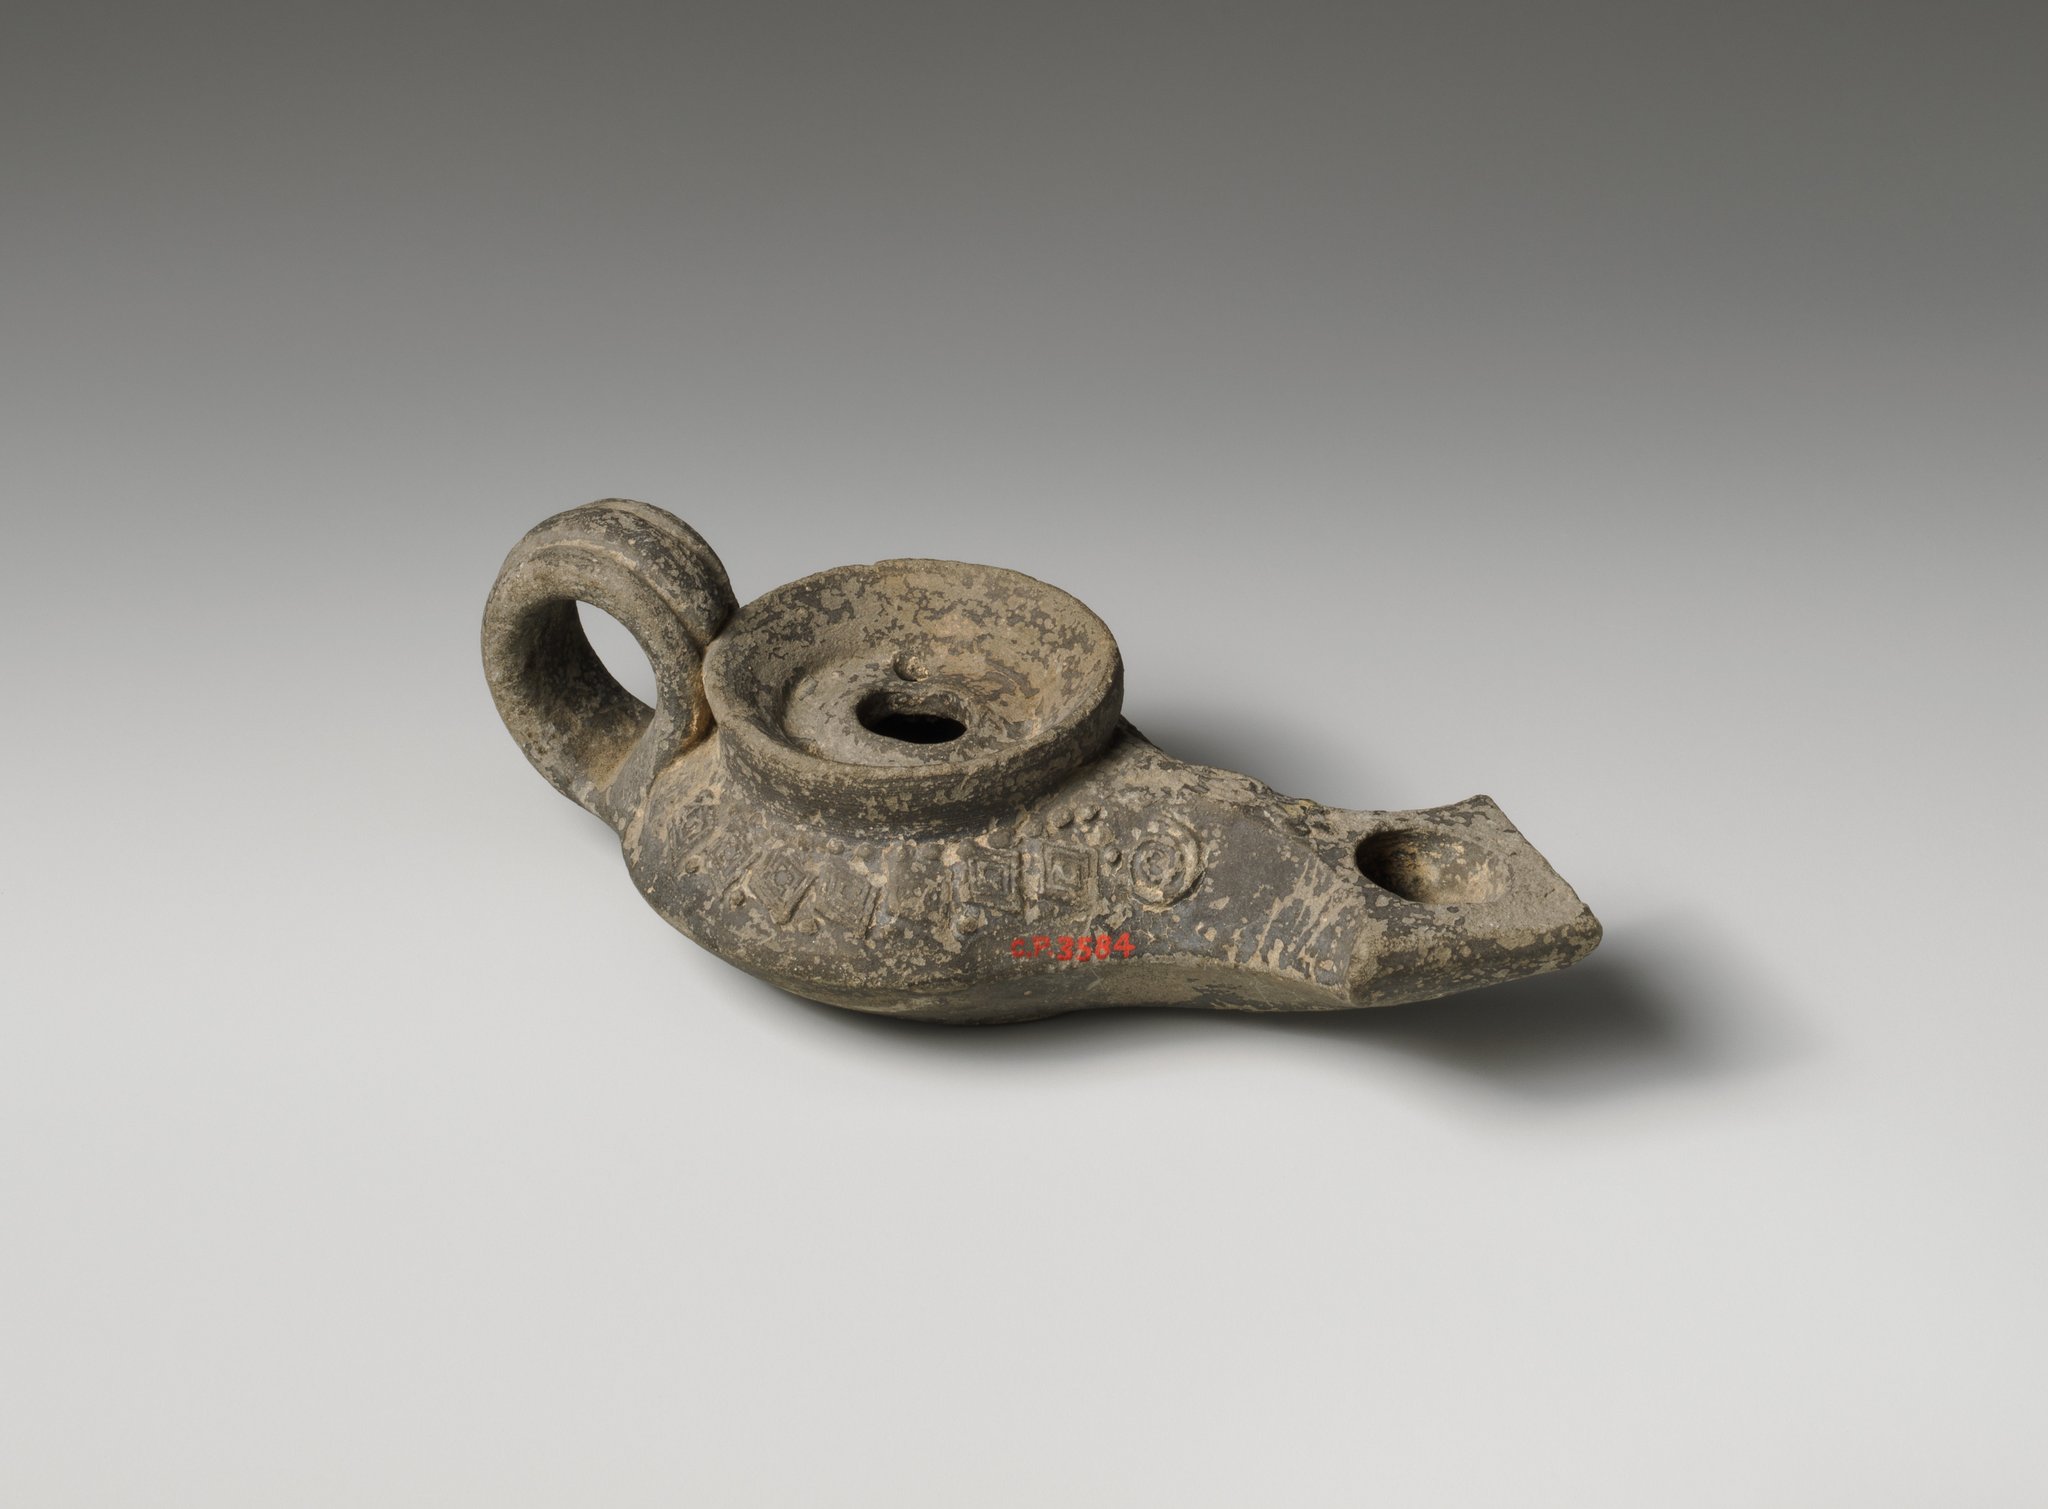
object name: lamp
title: Terracotta oil lamp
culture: greek, cypriot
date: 200-101 BCE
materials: terracotta